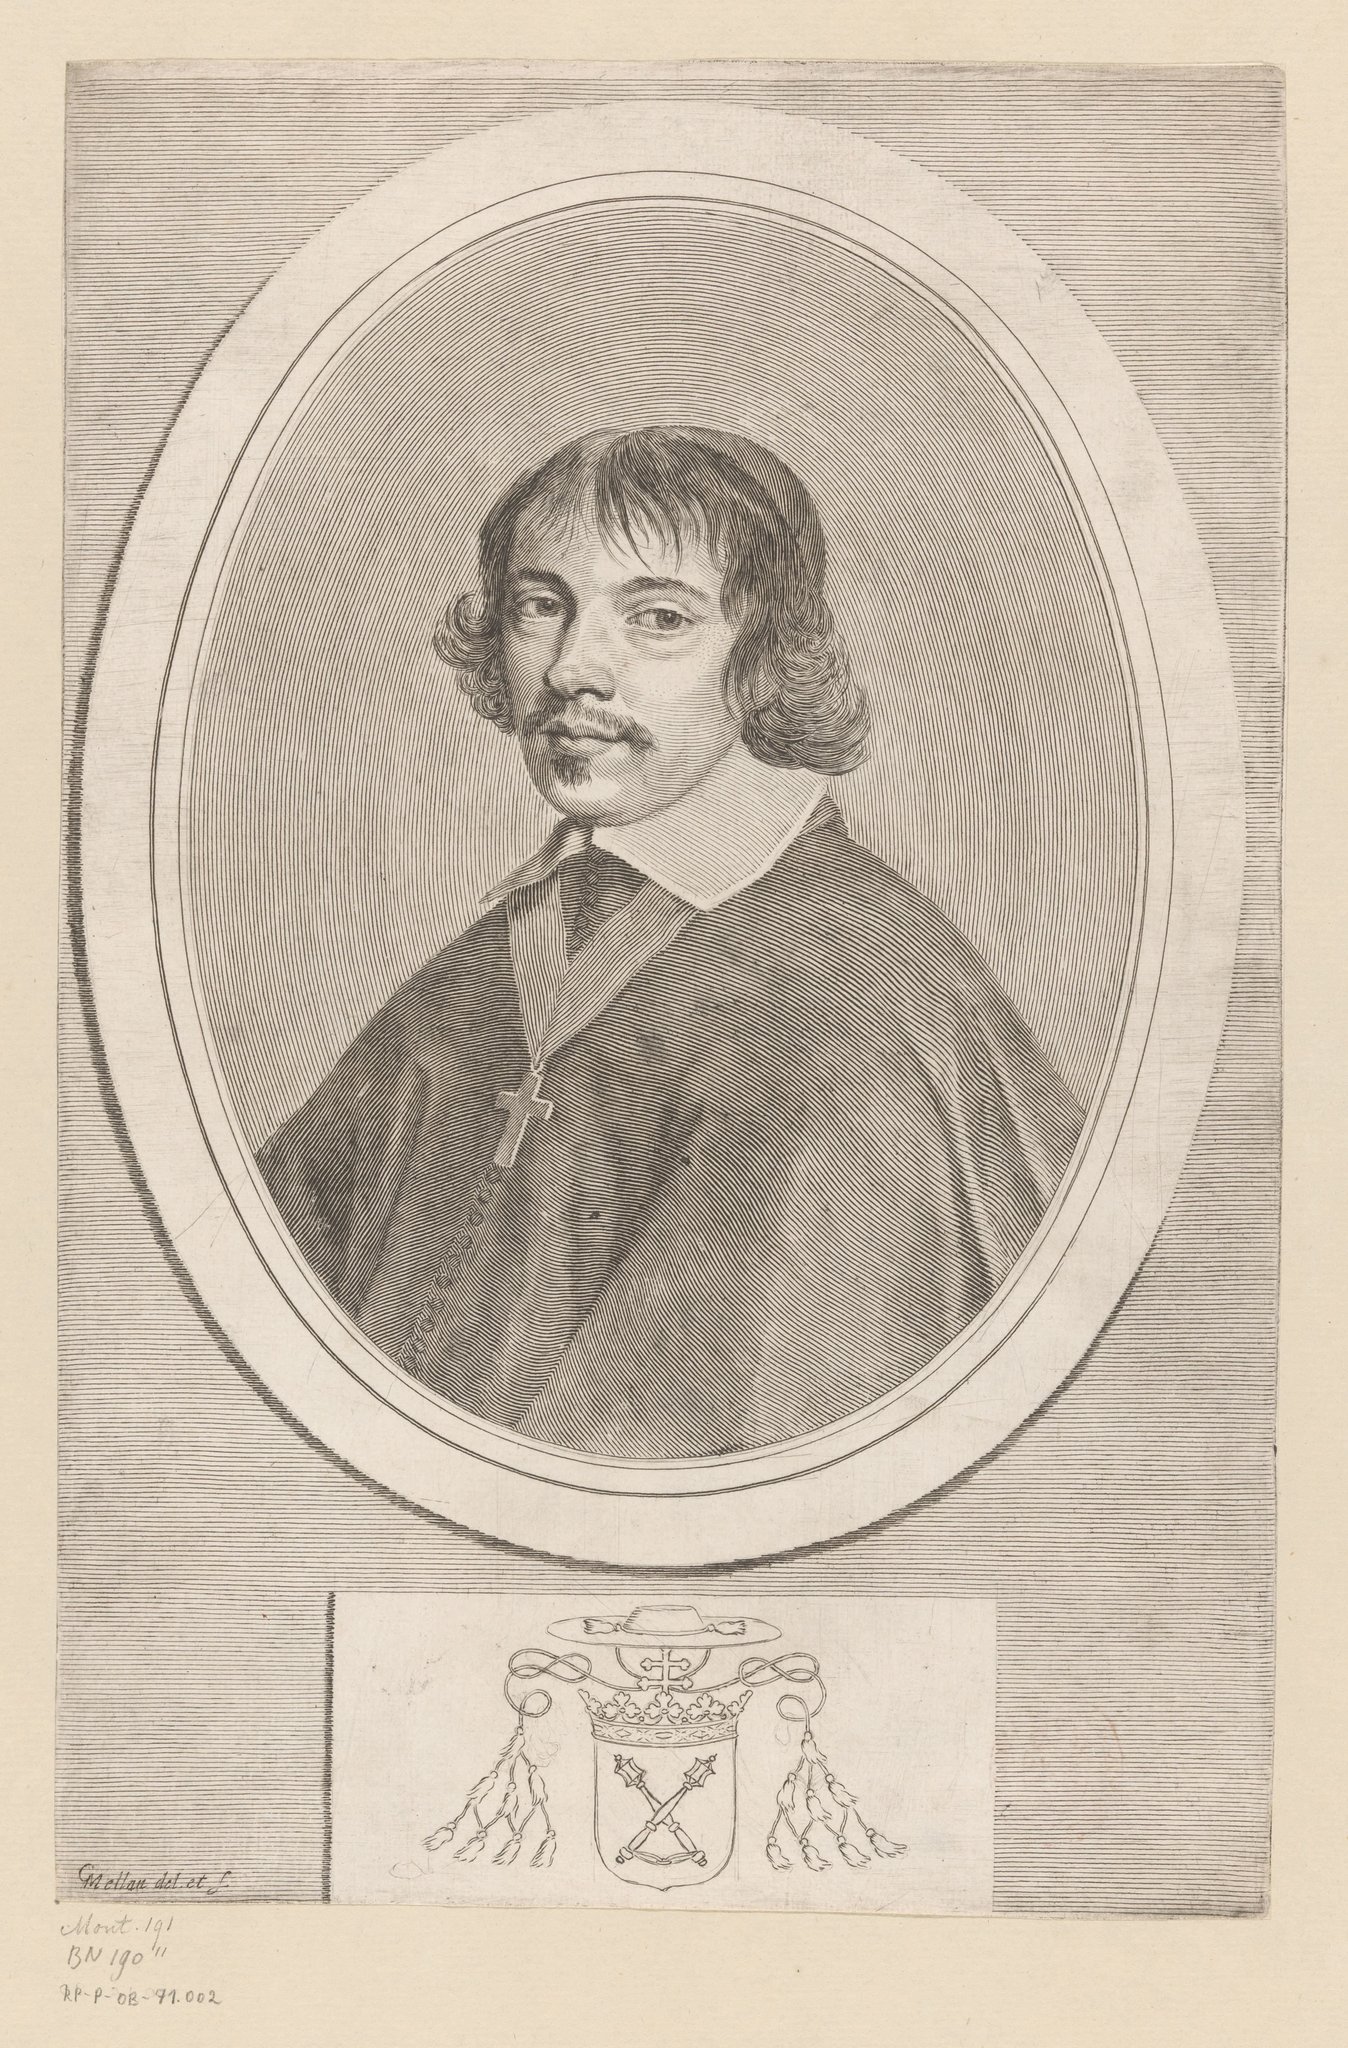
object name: print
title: Portret van Jean-François-Paul de Gondi, kardinaal van Retz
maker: claude mellan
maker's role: draughtsman, print maker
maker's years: 1598-1688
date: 1651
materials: paper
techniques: engraving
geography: france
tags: paris, cardinal, historical persons, armorial bearing, heraldry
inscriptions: collector's mark: Lugt 240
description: Voorbereidende tekening in: Hermitage Sint-Petersburg, inv. nr: 1818.